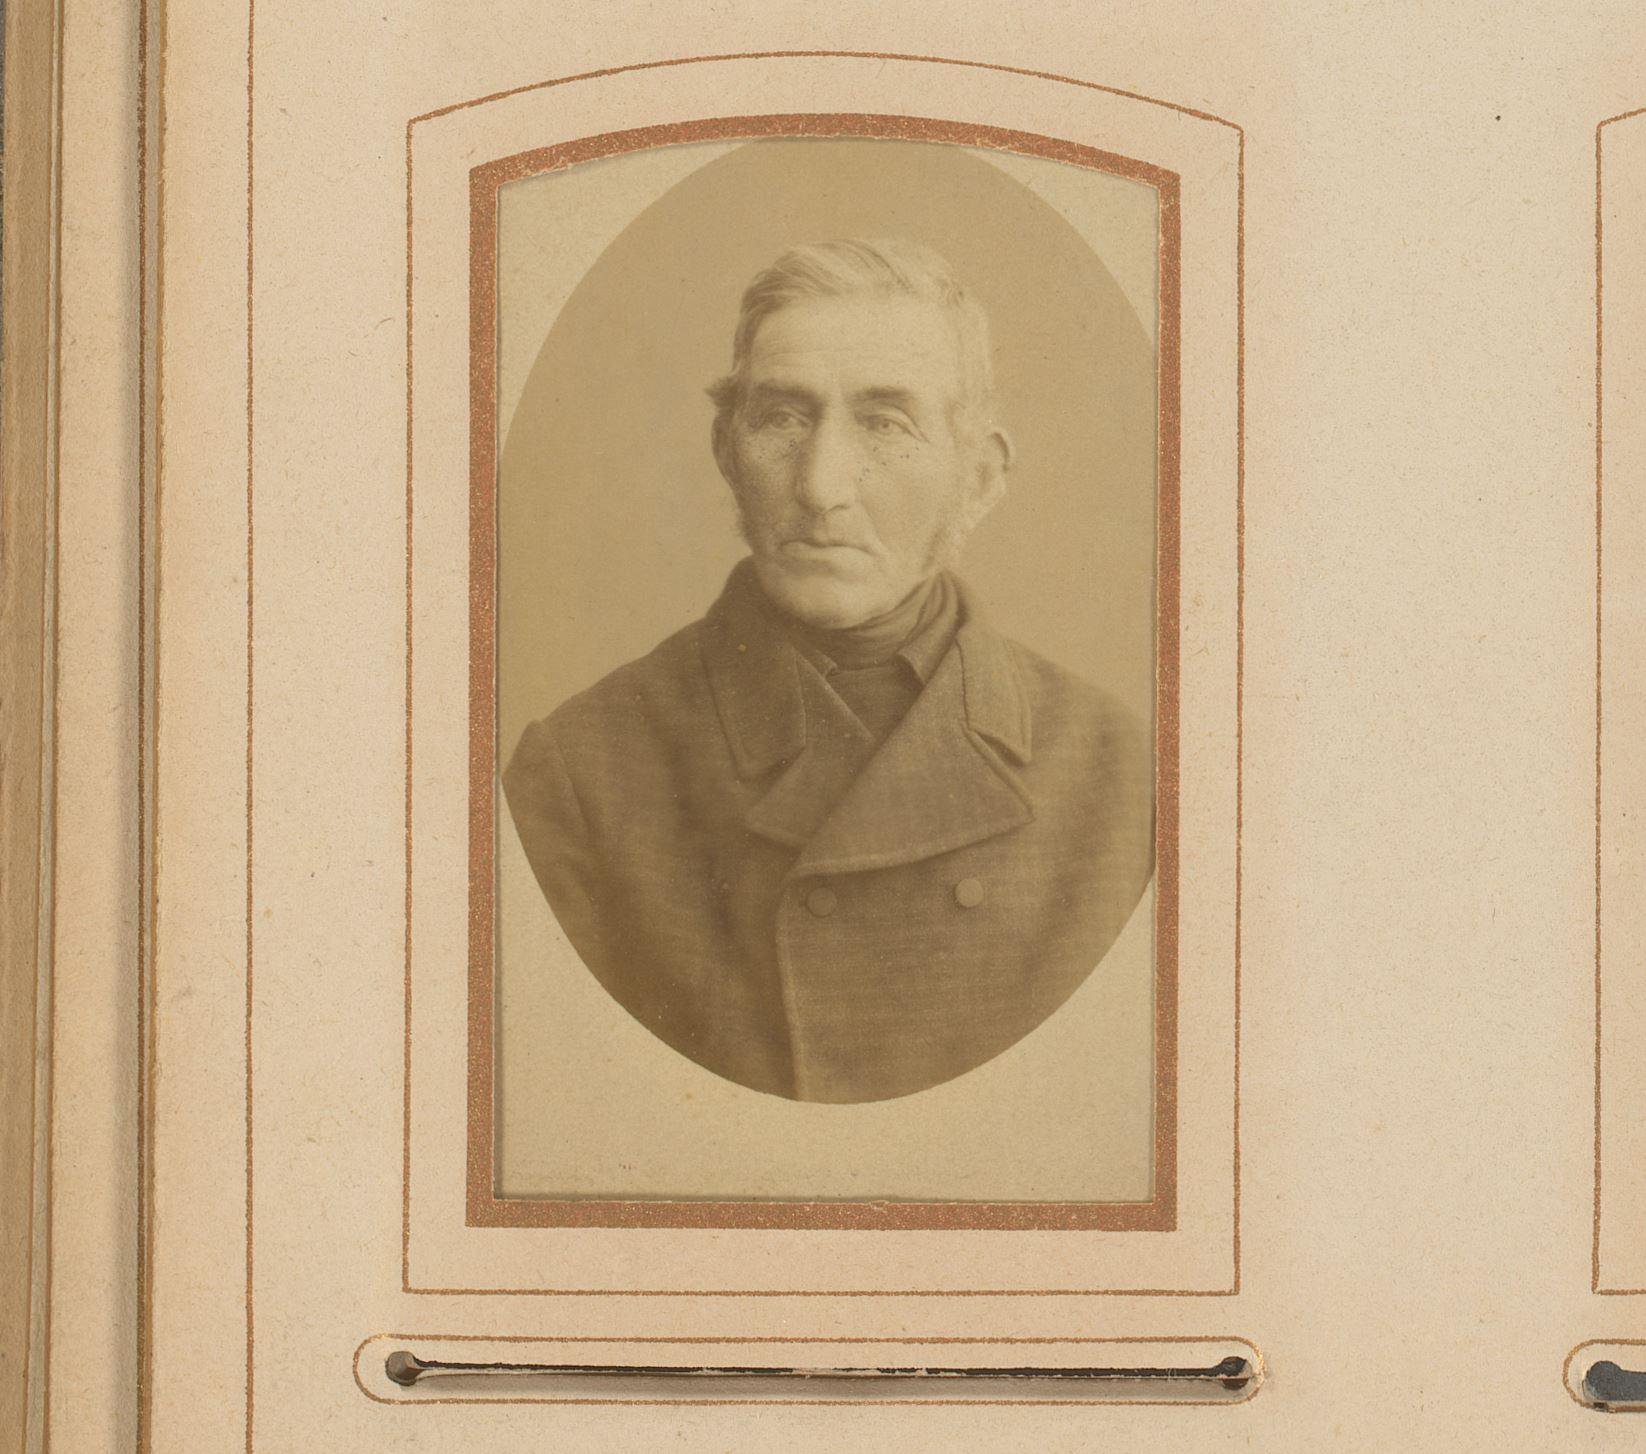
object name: photograph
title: Portret van een man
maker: george lodewijk smit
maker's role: painter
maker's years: 1854-1910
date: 1885-1893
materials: cardboard, photographic support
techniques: collodion silver print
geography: haarlem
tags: historical persons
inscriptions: inscription: ‘George L. Smit & Co./ Haarlem/ Smedestraat 28’